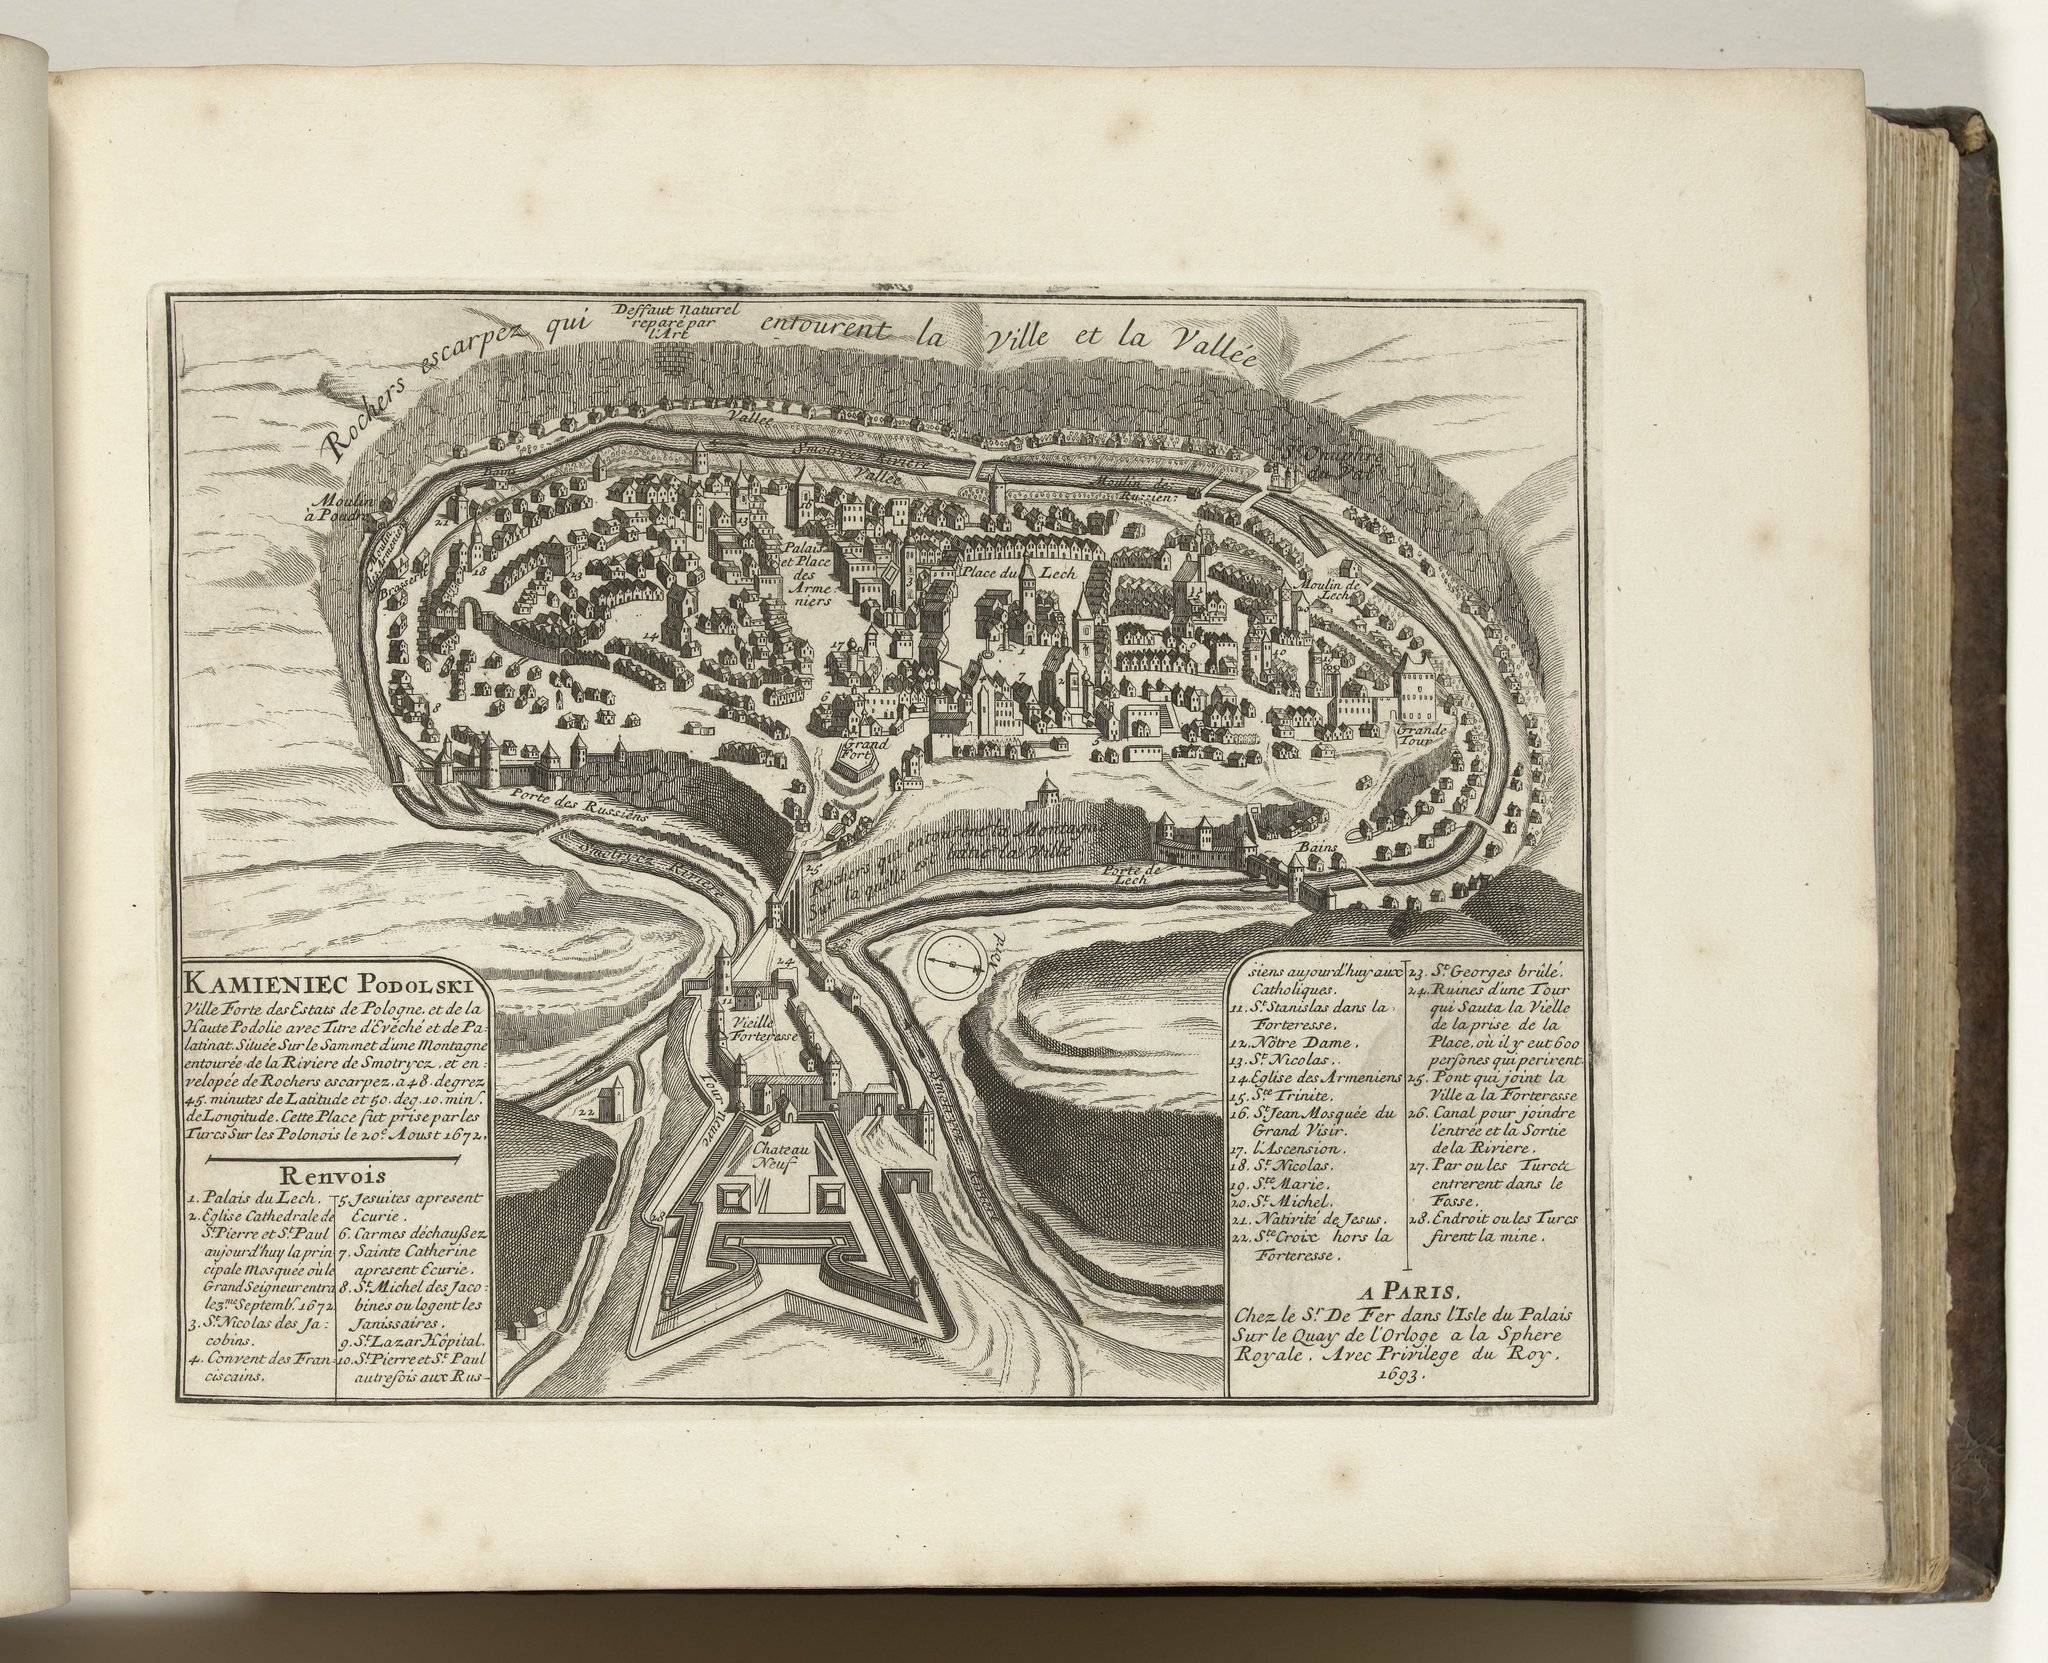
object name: print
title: Kamieniec Podolski Ville Forte des Estats de Pologne, et de la Haute Podolie (...)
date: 1693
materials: paper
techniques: etching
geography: france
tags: maps of cities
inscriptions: date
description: Plattegrond van de stad Kamjanets-Podilsky. Onderdeel van het tweede deel (1693) van het prentwerk waarin gebundeld zijn de acht delen van Les forces de l'Europe uitgegeven tussen 1693-1697. Het prentwerk bestaat uit 175 platen met plannen (afkomstig van Sébastien Le Prestre, Seigneur de Vauban) van vermaarde sterke steden en vestingen in de Negenjarige Oorlog. Titel en opschriften in het Frans.